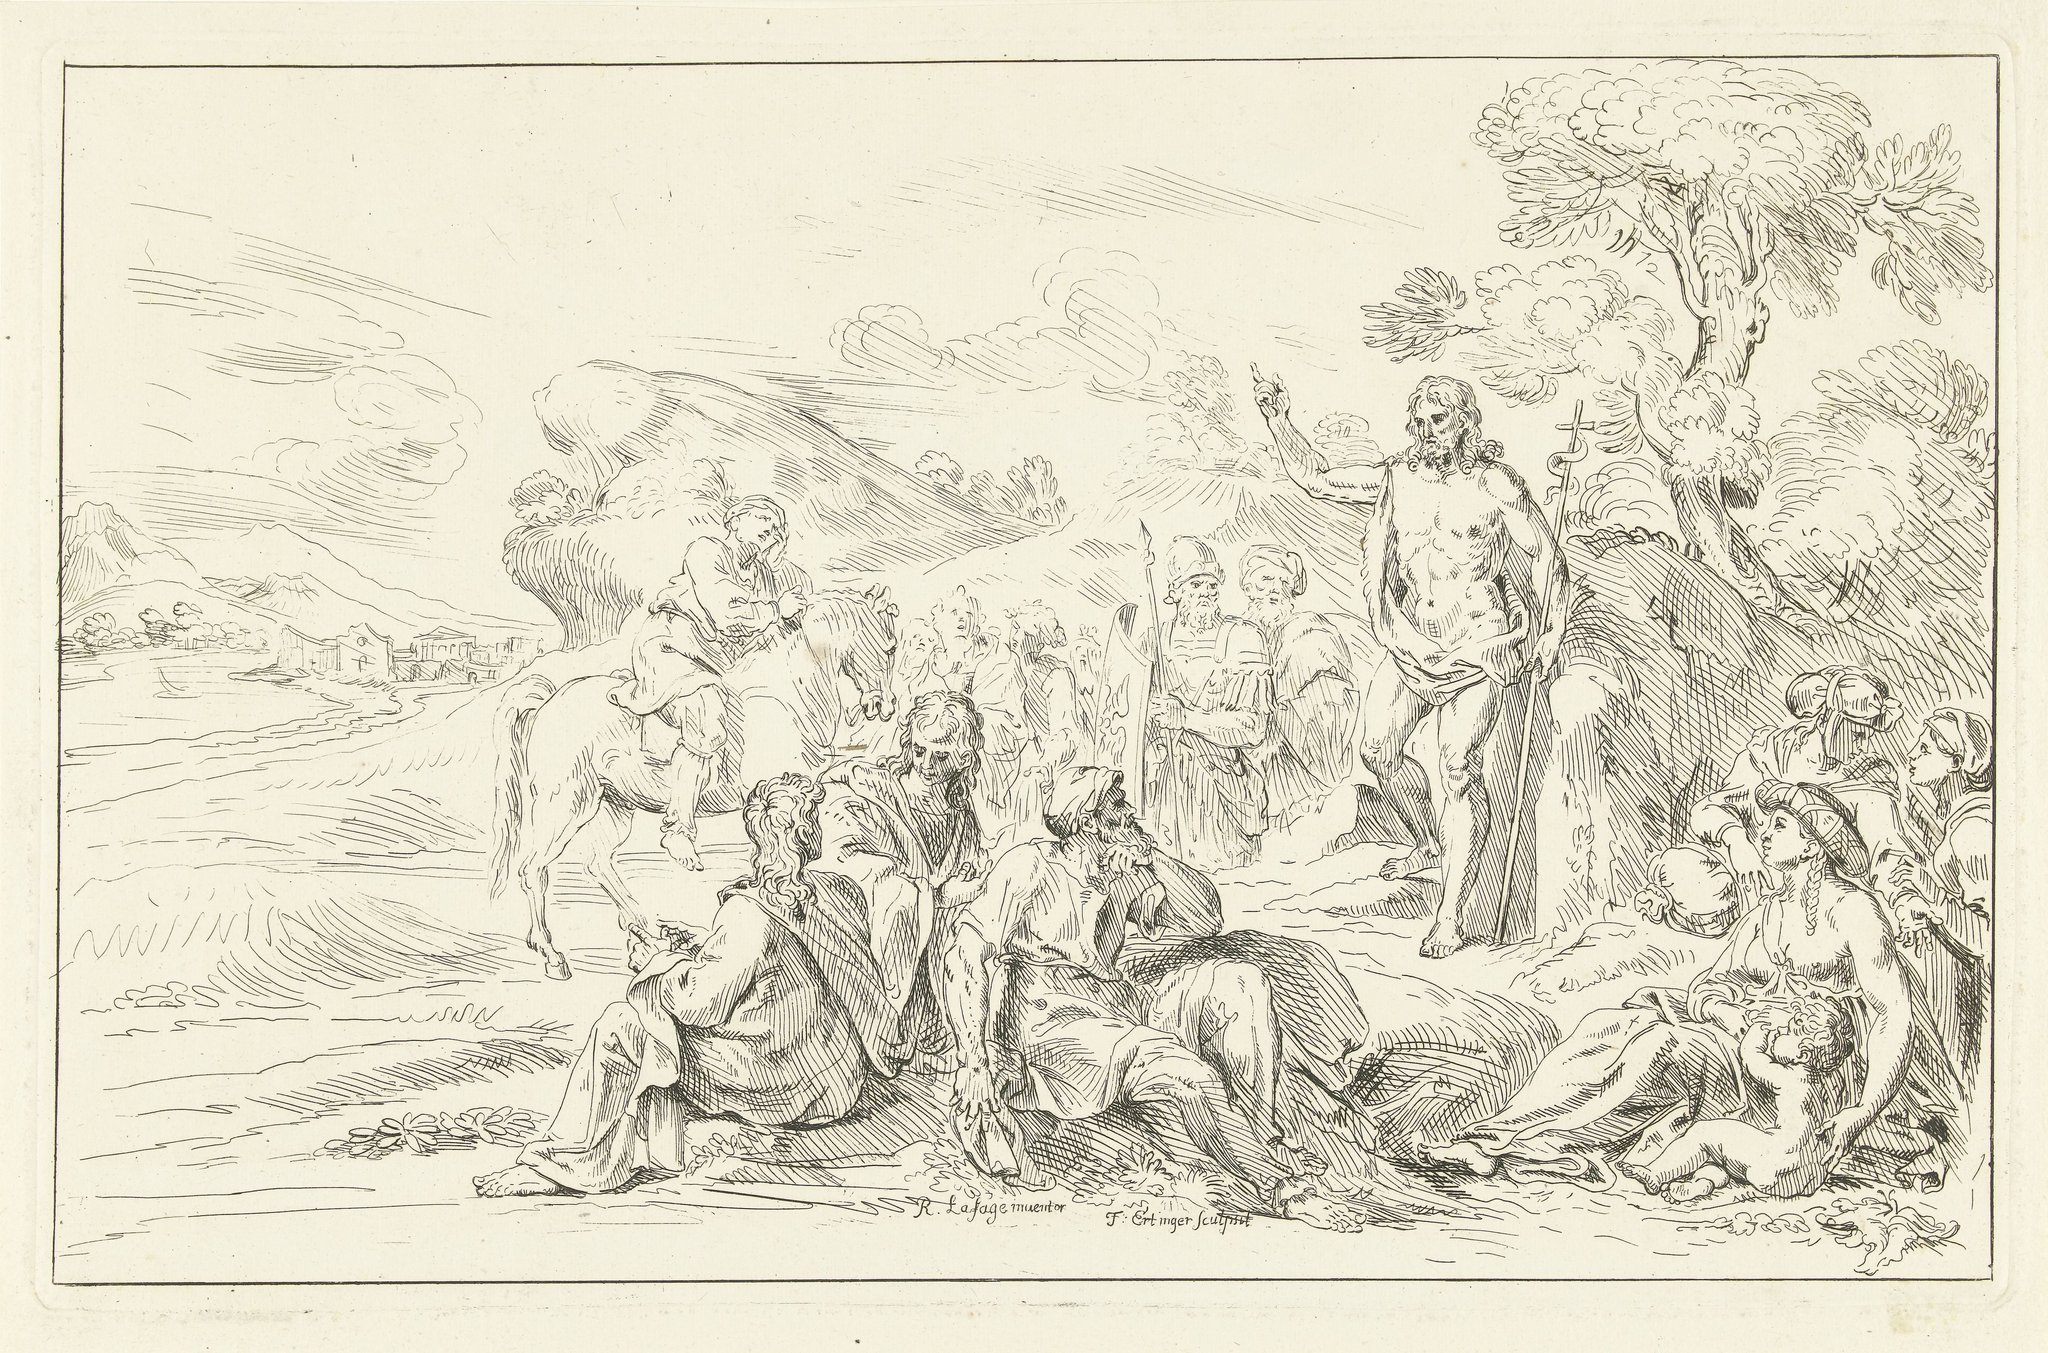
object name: print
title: Prediking van Johannes de Doper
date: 1652-1707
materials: paper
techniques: etching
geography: paris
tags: john the baptist preaching (perhaps christ among the bystanders)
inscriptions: collector's mark: Lugt 2165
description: Johannes de Doper, met staf waaraan een lint hangt, predikt voor een zittend gezelschap. Op de achtergrond meer toehoorders waaronder een man te paard en de Romeins soldaat.